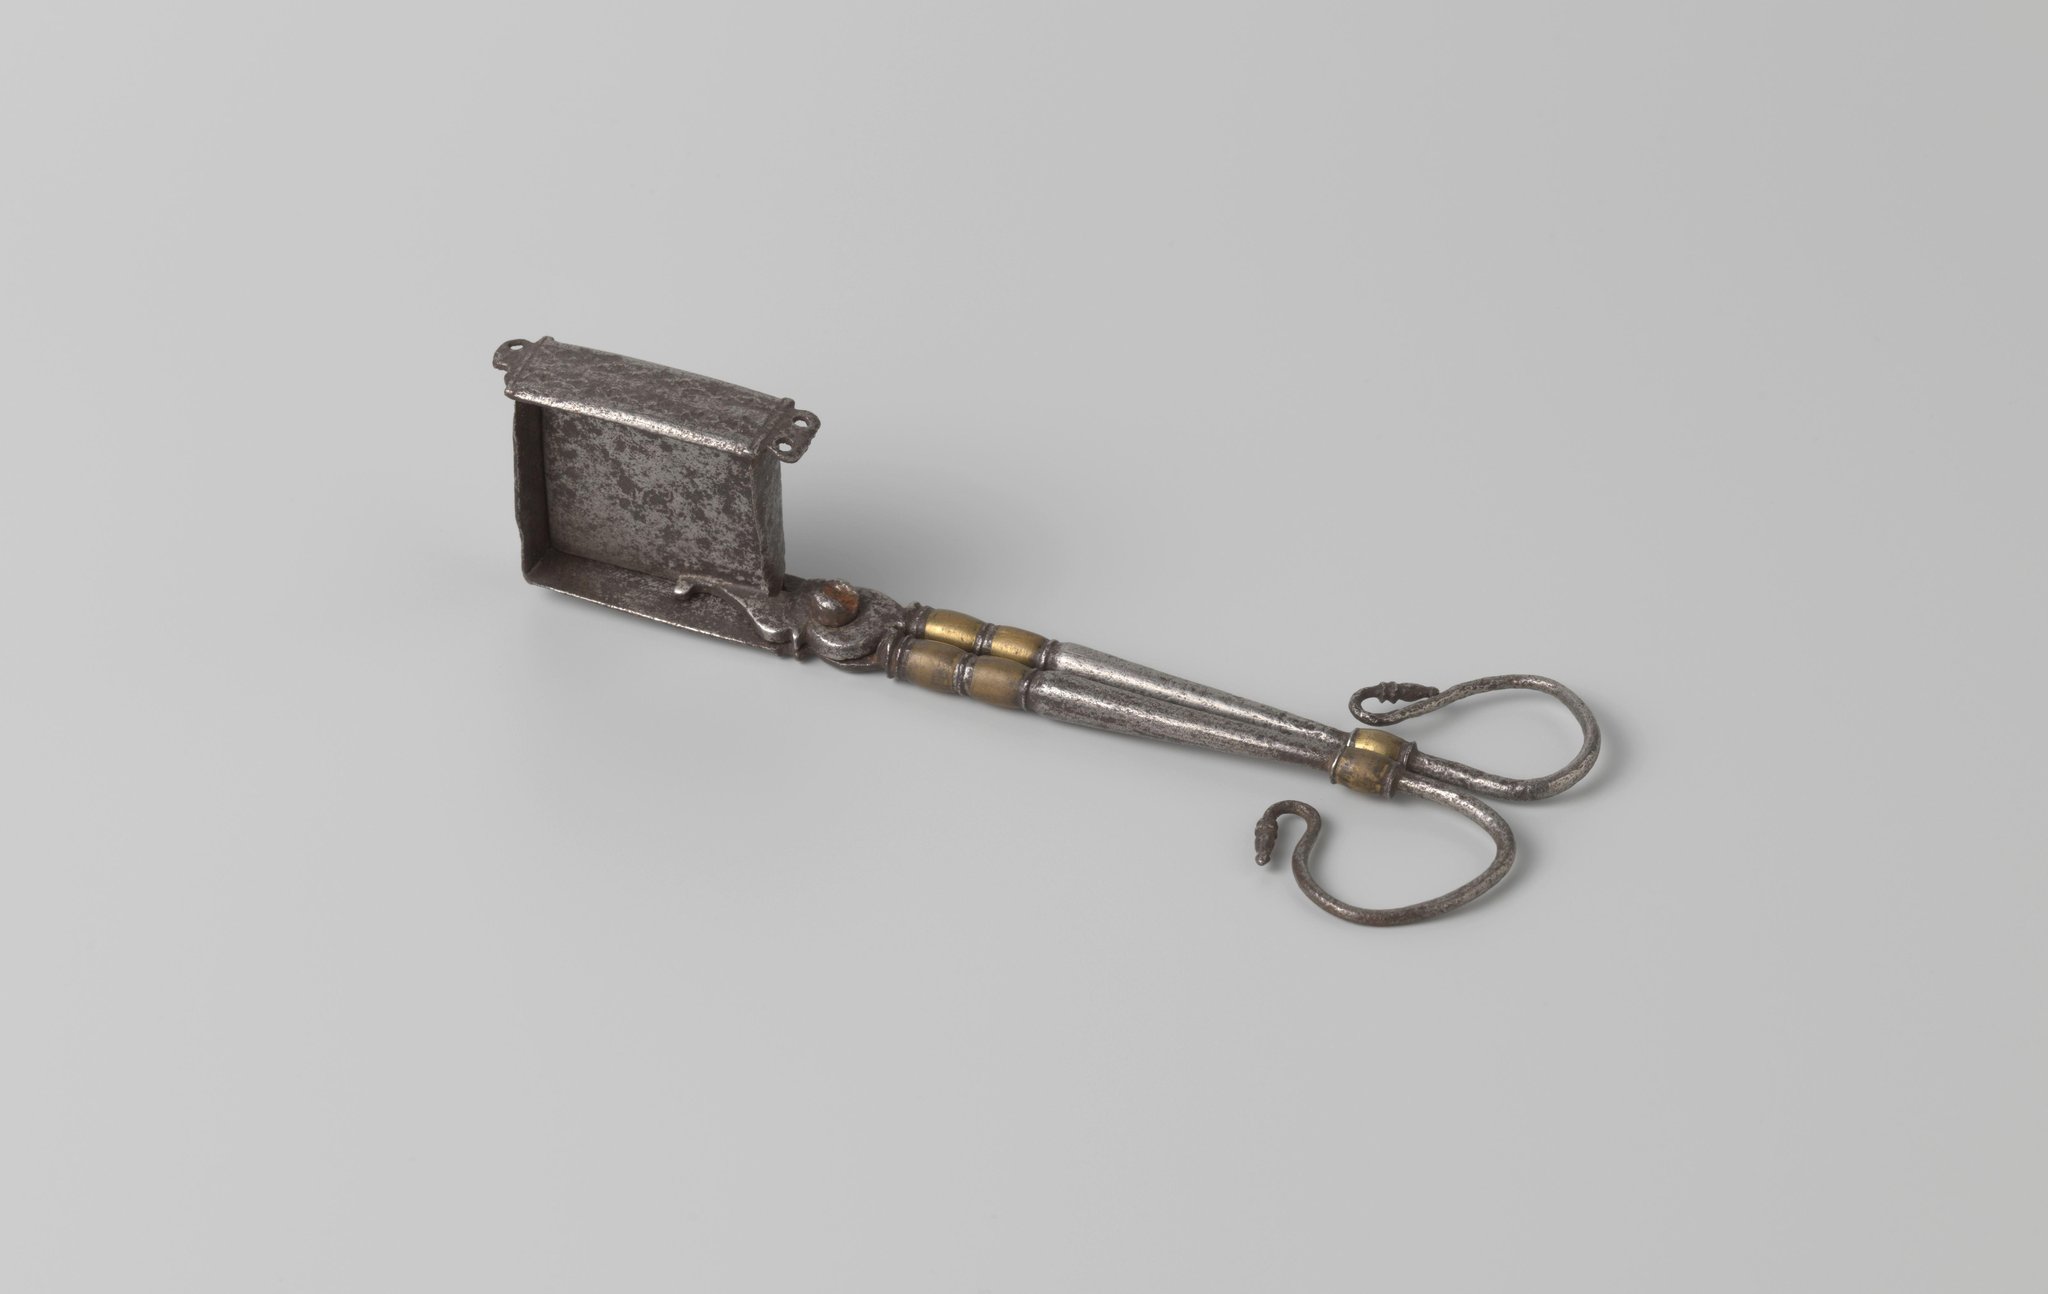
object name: snuiter, snuiterschaar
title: Snuiter van ijzer met koperen band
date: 1575-1600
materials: copper, iron